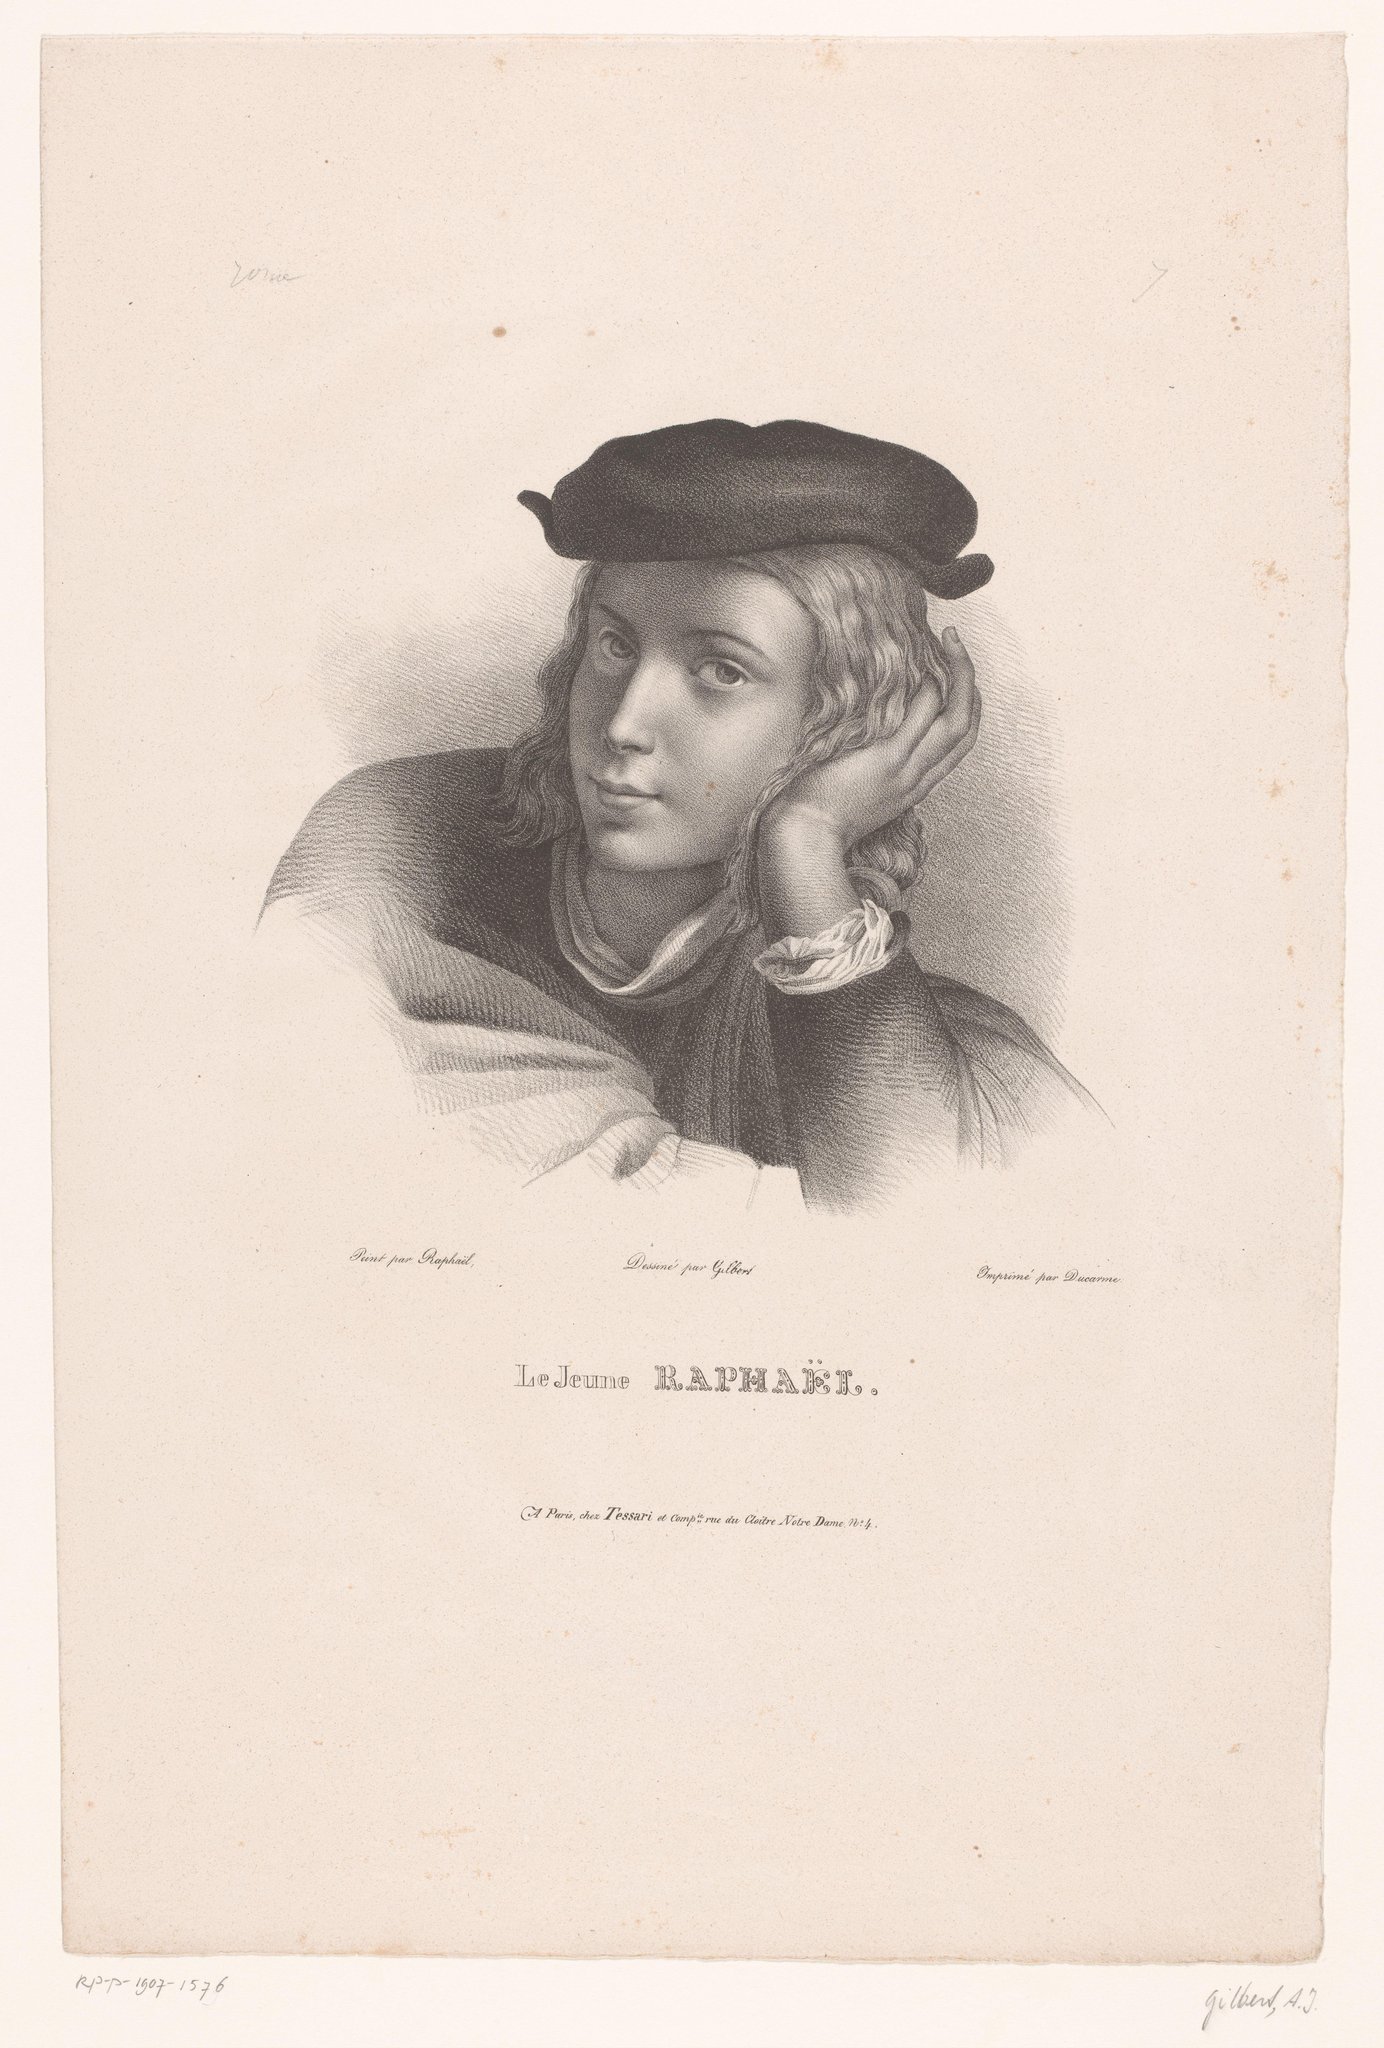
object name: print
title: Le jeune Raphaël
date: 1829-1830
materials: paper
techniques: lithograph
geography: paris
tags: rome, painter, rafaël, historical persons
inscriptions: collector's mark: Lugt 2228a